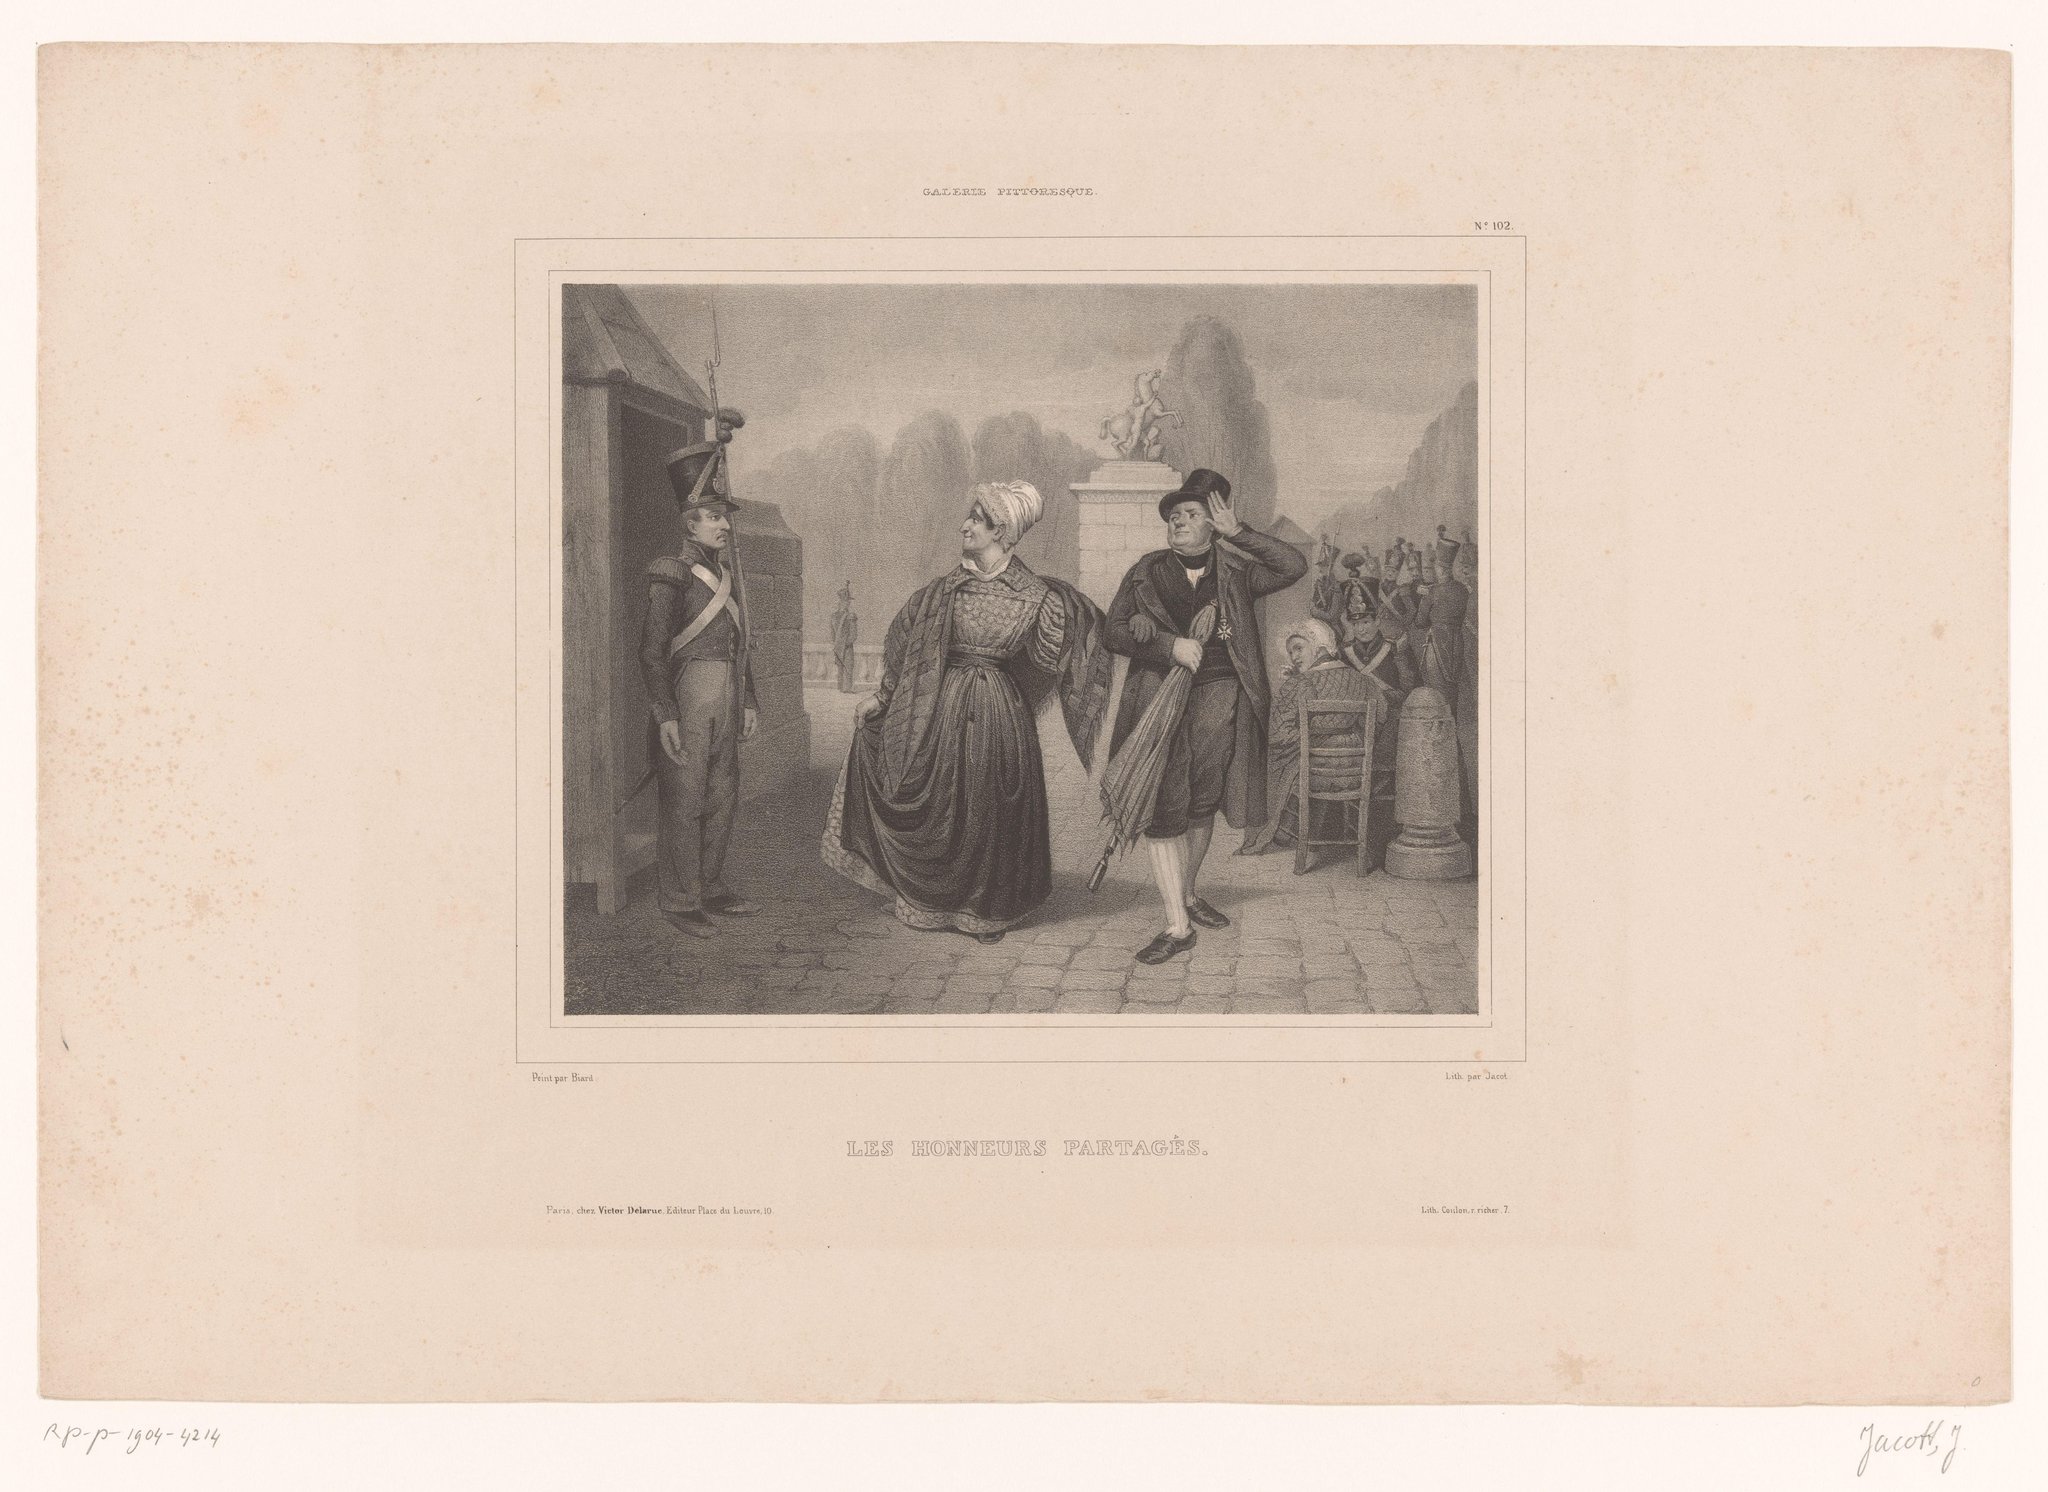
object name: print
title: Galerie pittoresque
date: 1837-1849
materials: paper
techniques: lithograph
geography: paris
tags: saluting, guard duty, keeping sentry, military salutes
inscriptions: collector's mark: Lugt 2228a